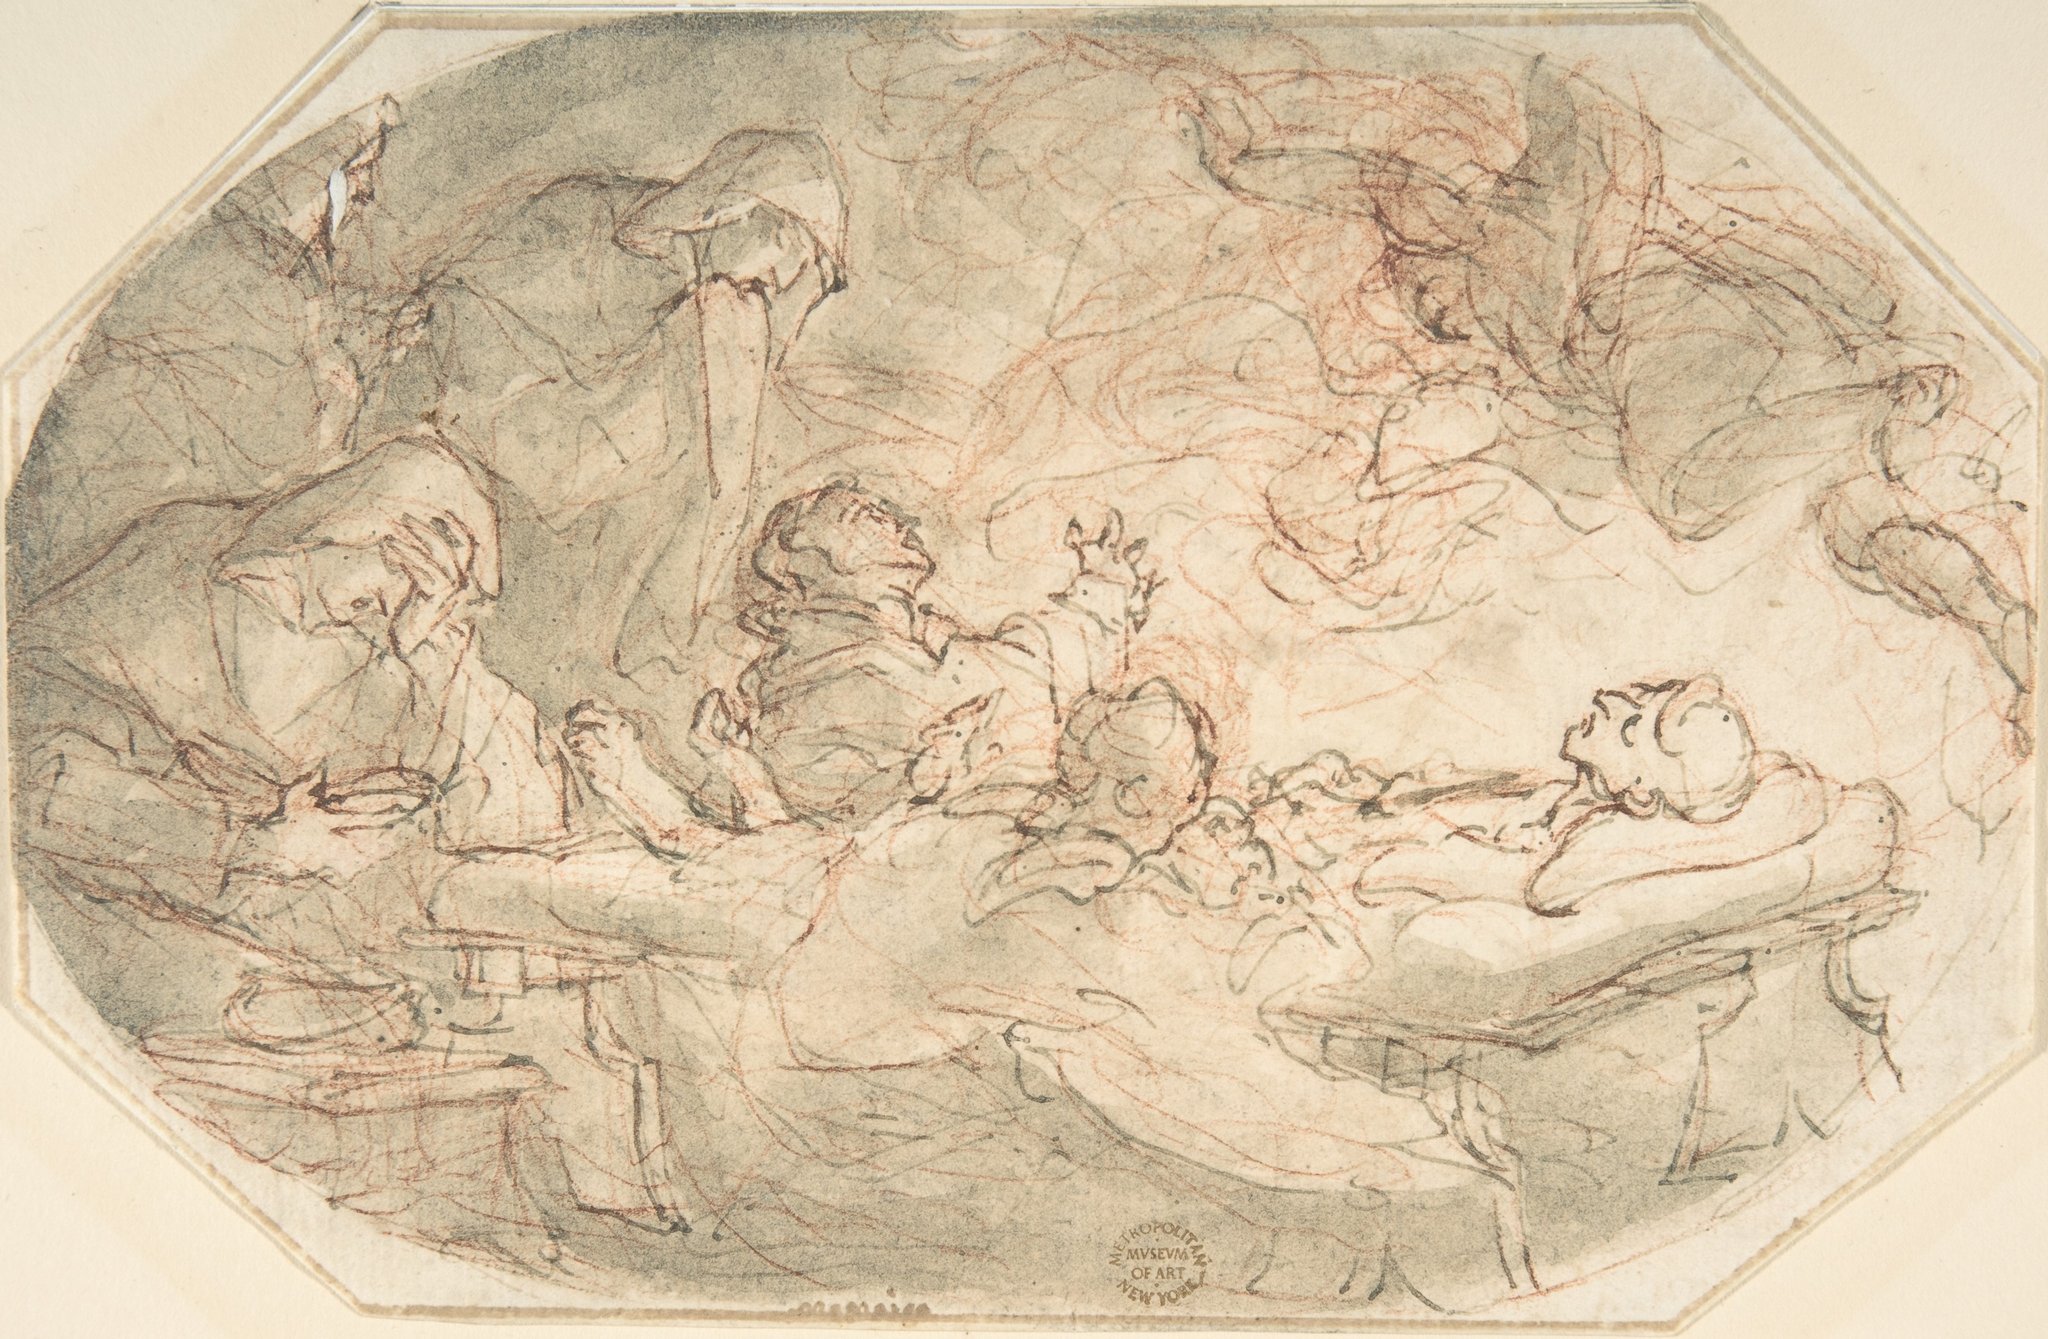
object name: drawing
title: Death of a Saint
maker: anonymous, italian, 17th or 18th century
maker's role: artist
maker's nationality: italian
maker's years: 1600-1799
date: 1600-1800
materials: chalk, ink, paper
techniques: brush, pen, wash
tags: sadness,saints,death